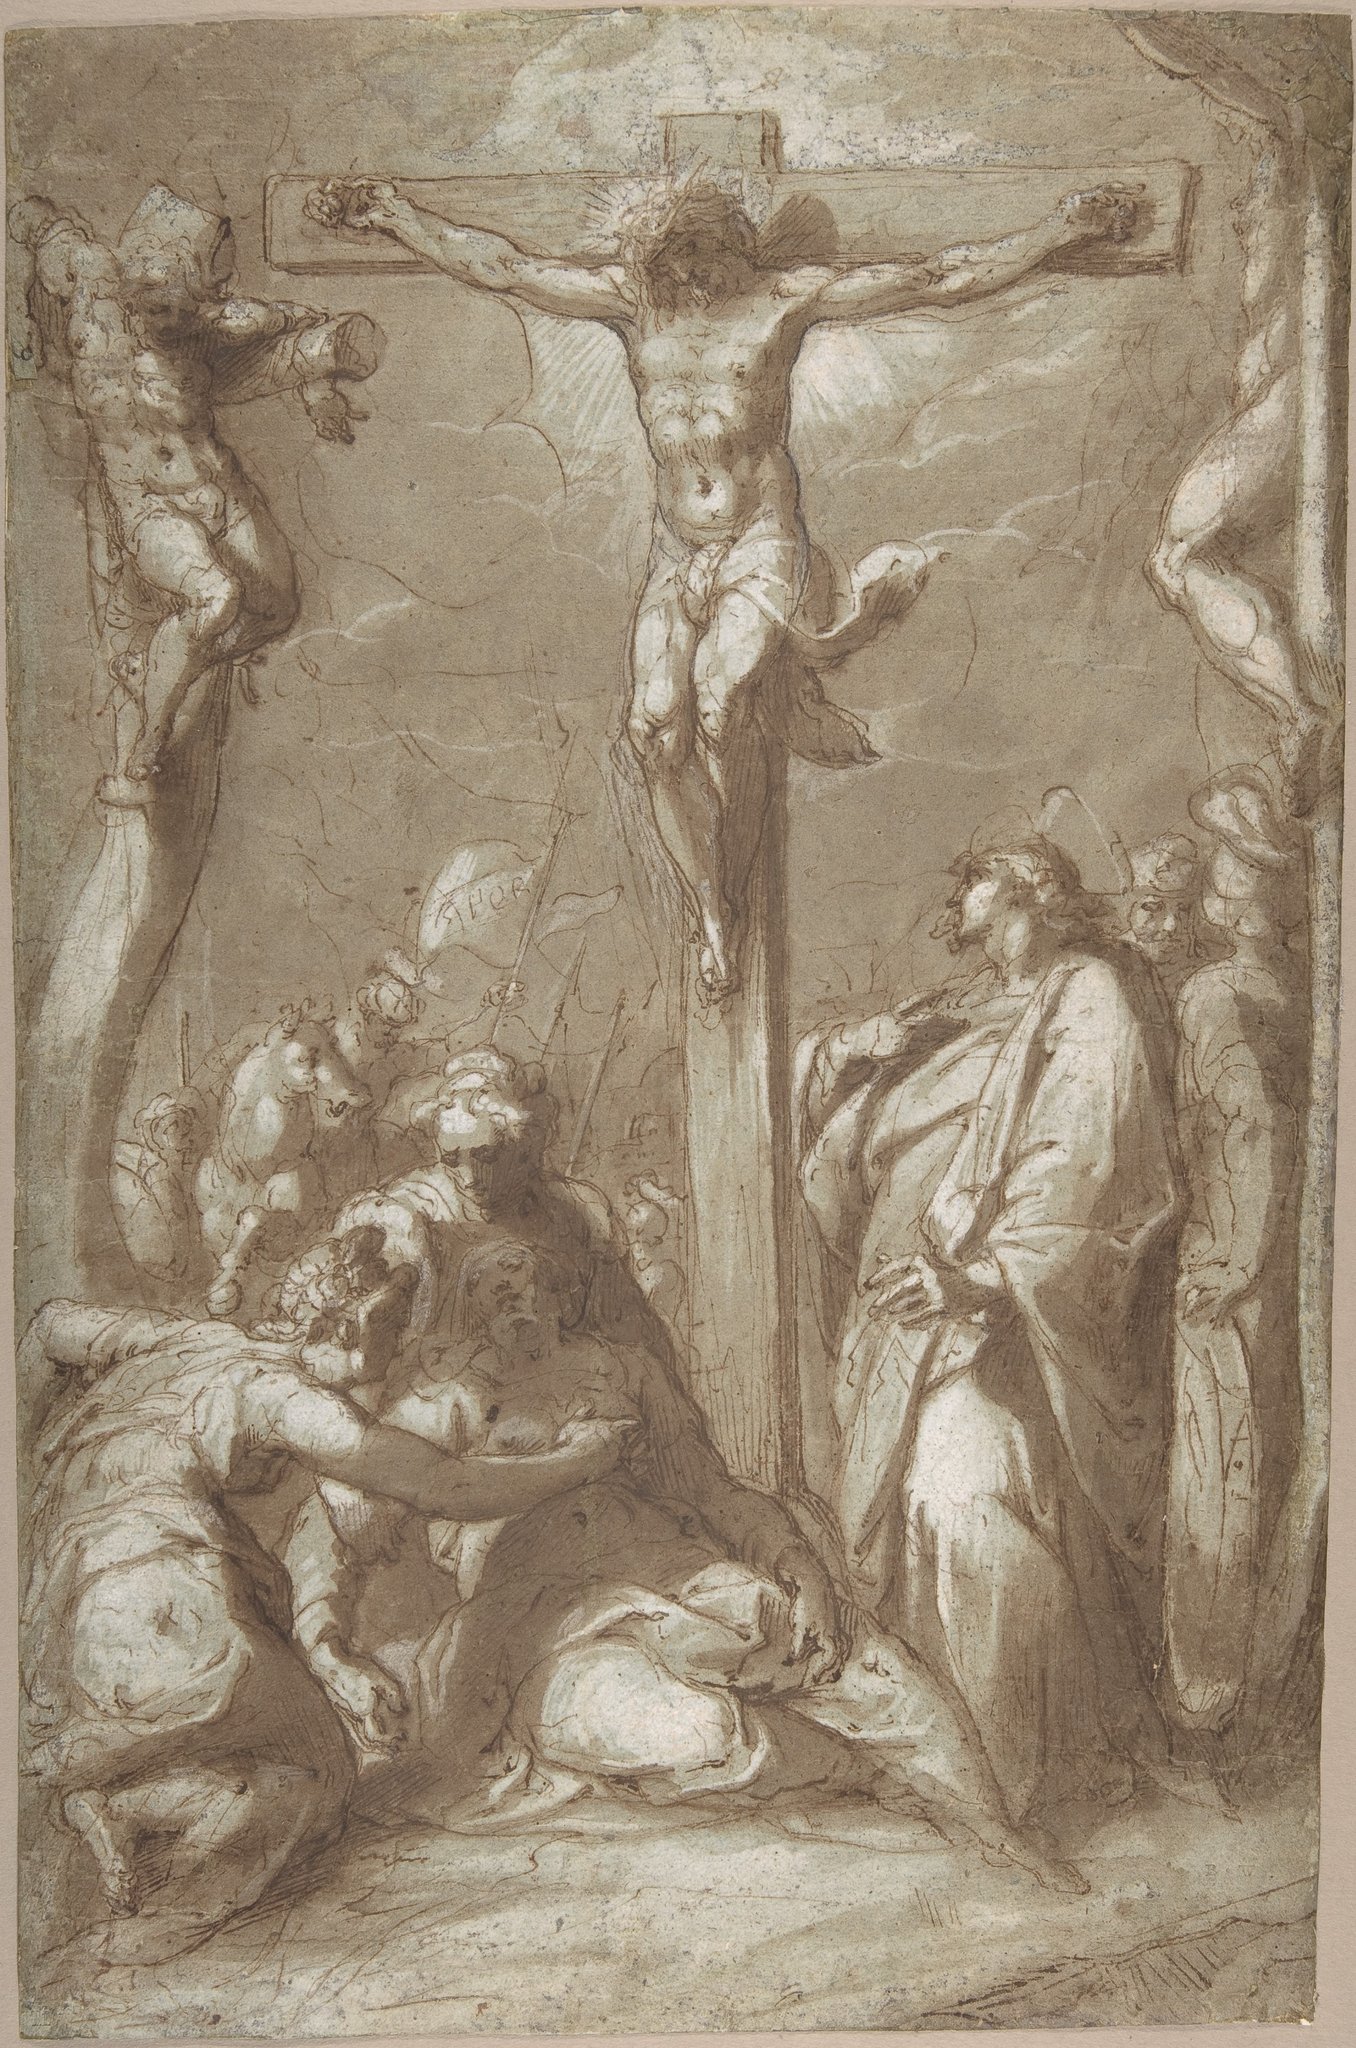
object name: drawing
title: The Crucifixion of Christ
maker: hans speckaert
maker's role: artist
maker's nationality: netherlandish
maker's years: -1577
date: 1577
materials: gouache, ink, paper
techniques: brush, heightening, pen, wash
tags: christ,crucifixion